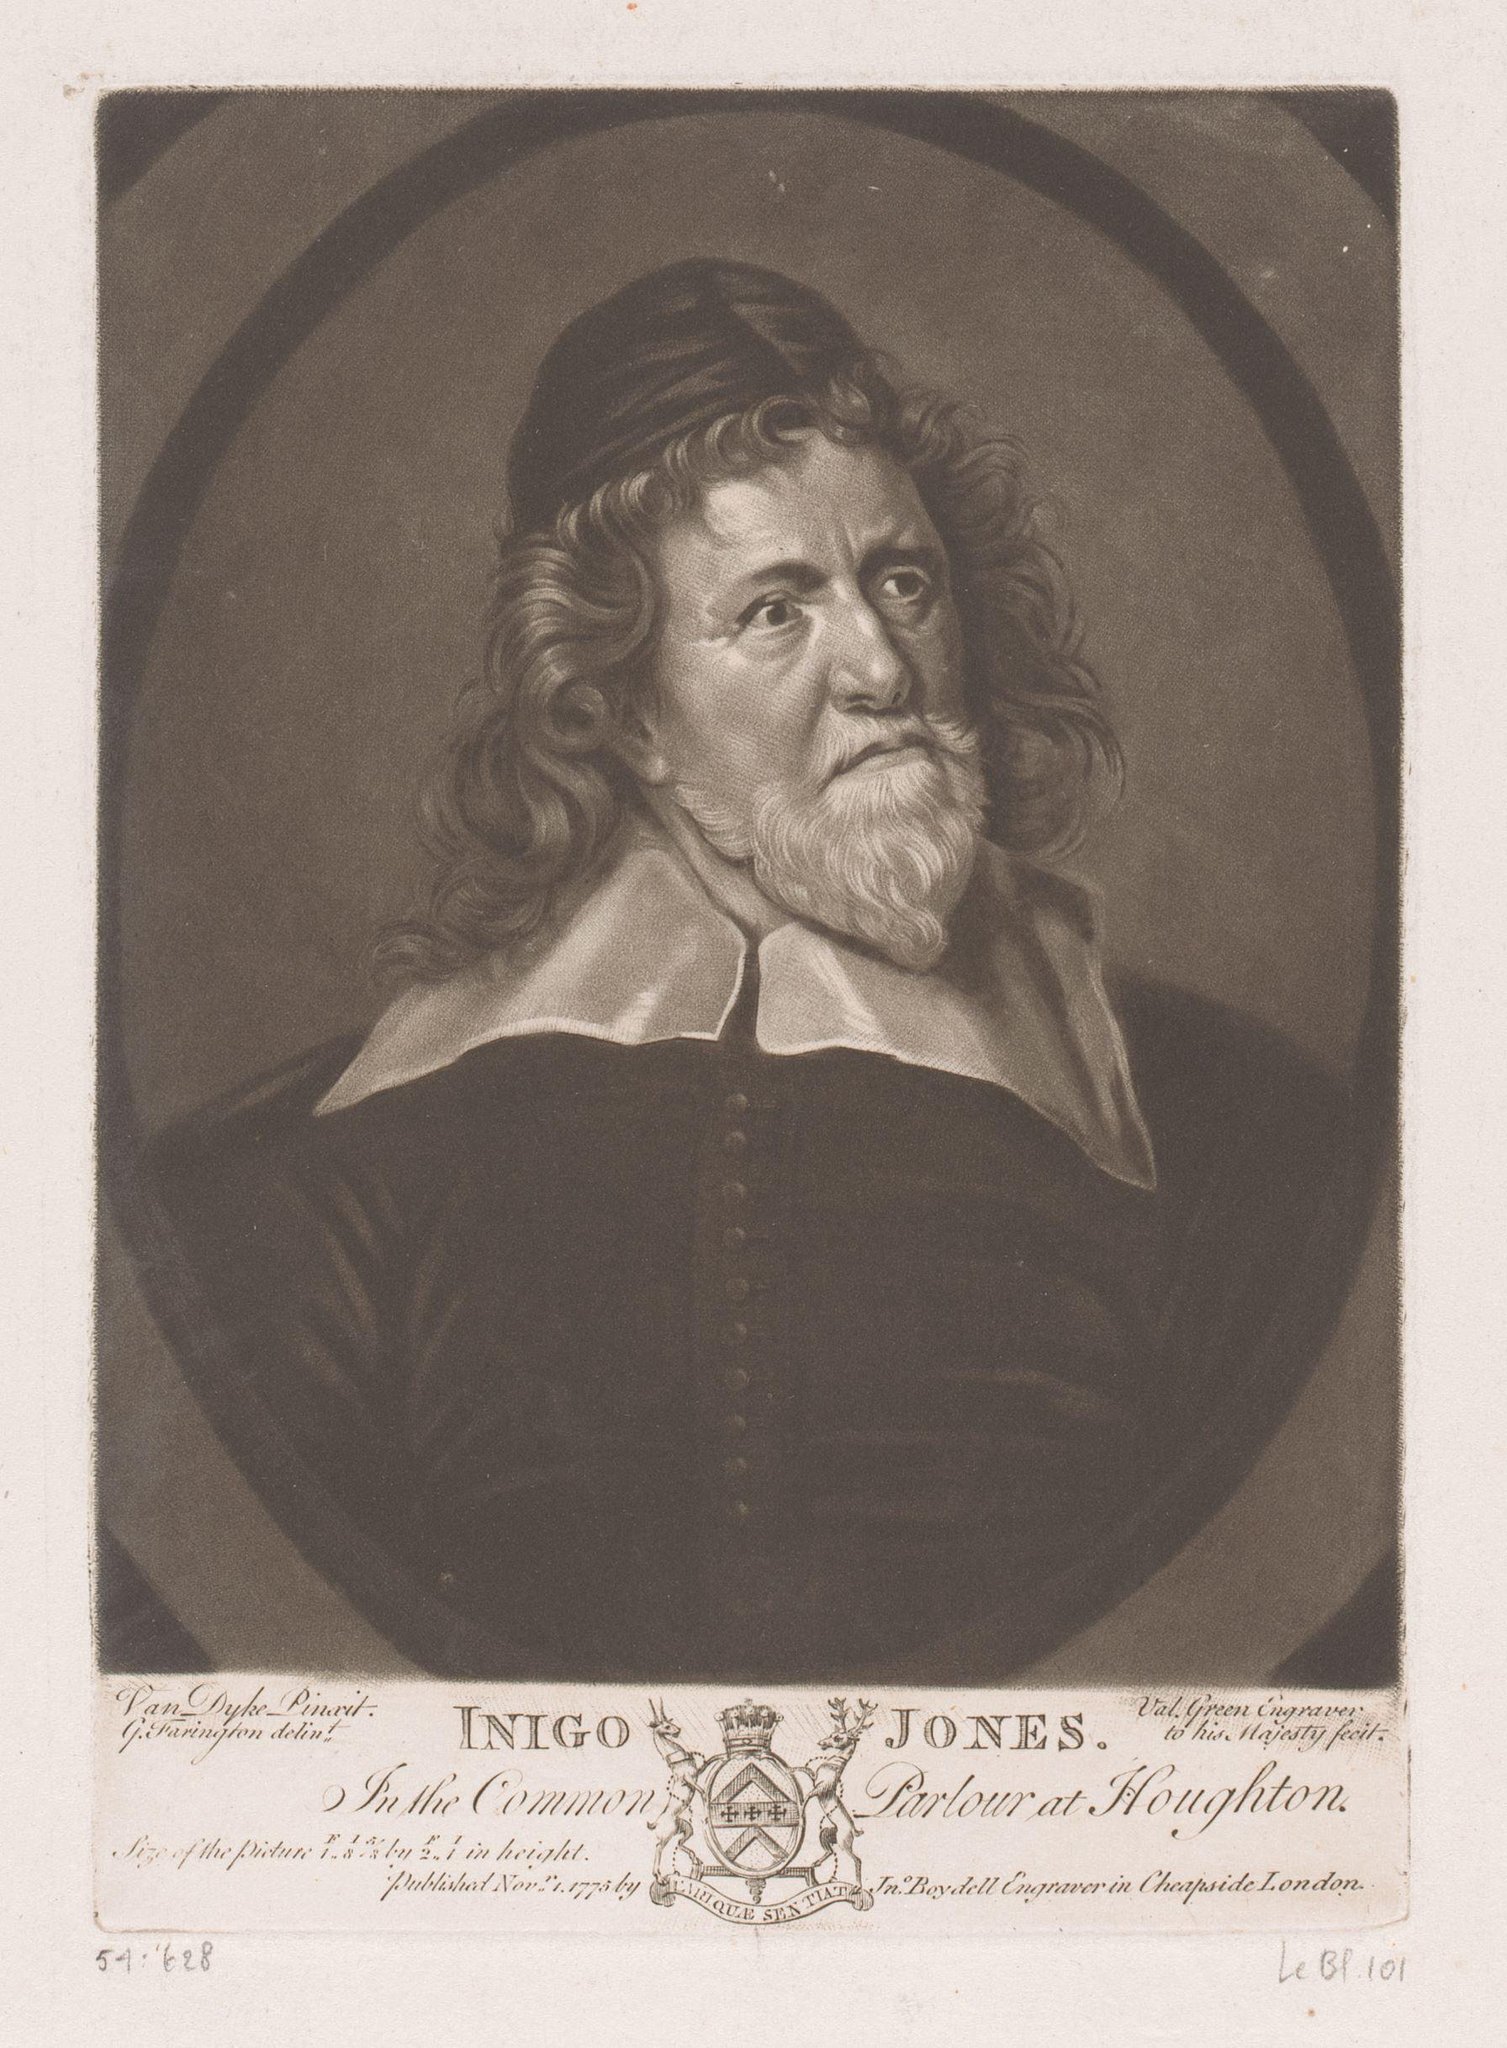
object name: print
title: Portret van Inigo Jones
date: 1775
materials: paper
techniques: etching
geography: london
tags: london, inigo jones, historical persons, portrait, self-portrait of architect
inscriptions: collector's mark: Lugt 2228, collector's mark: Lugt 2760